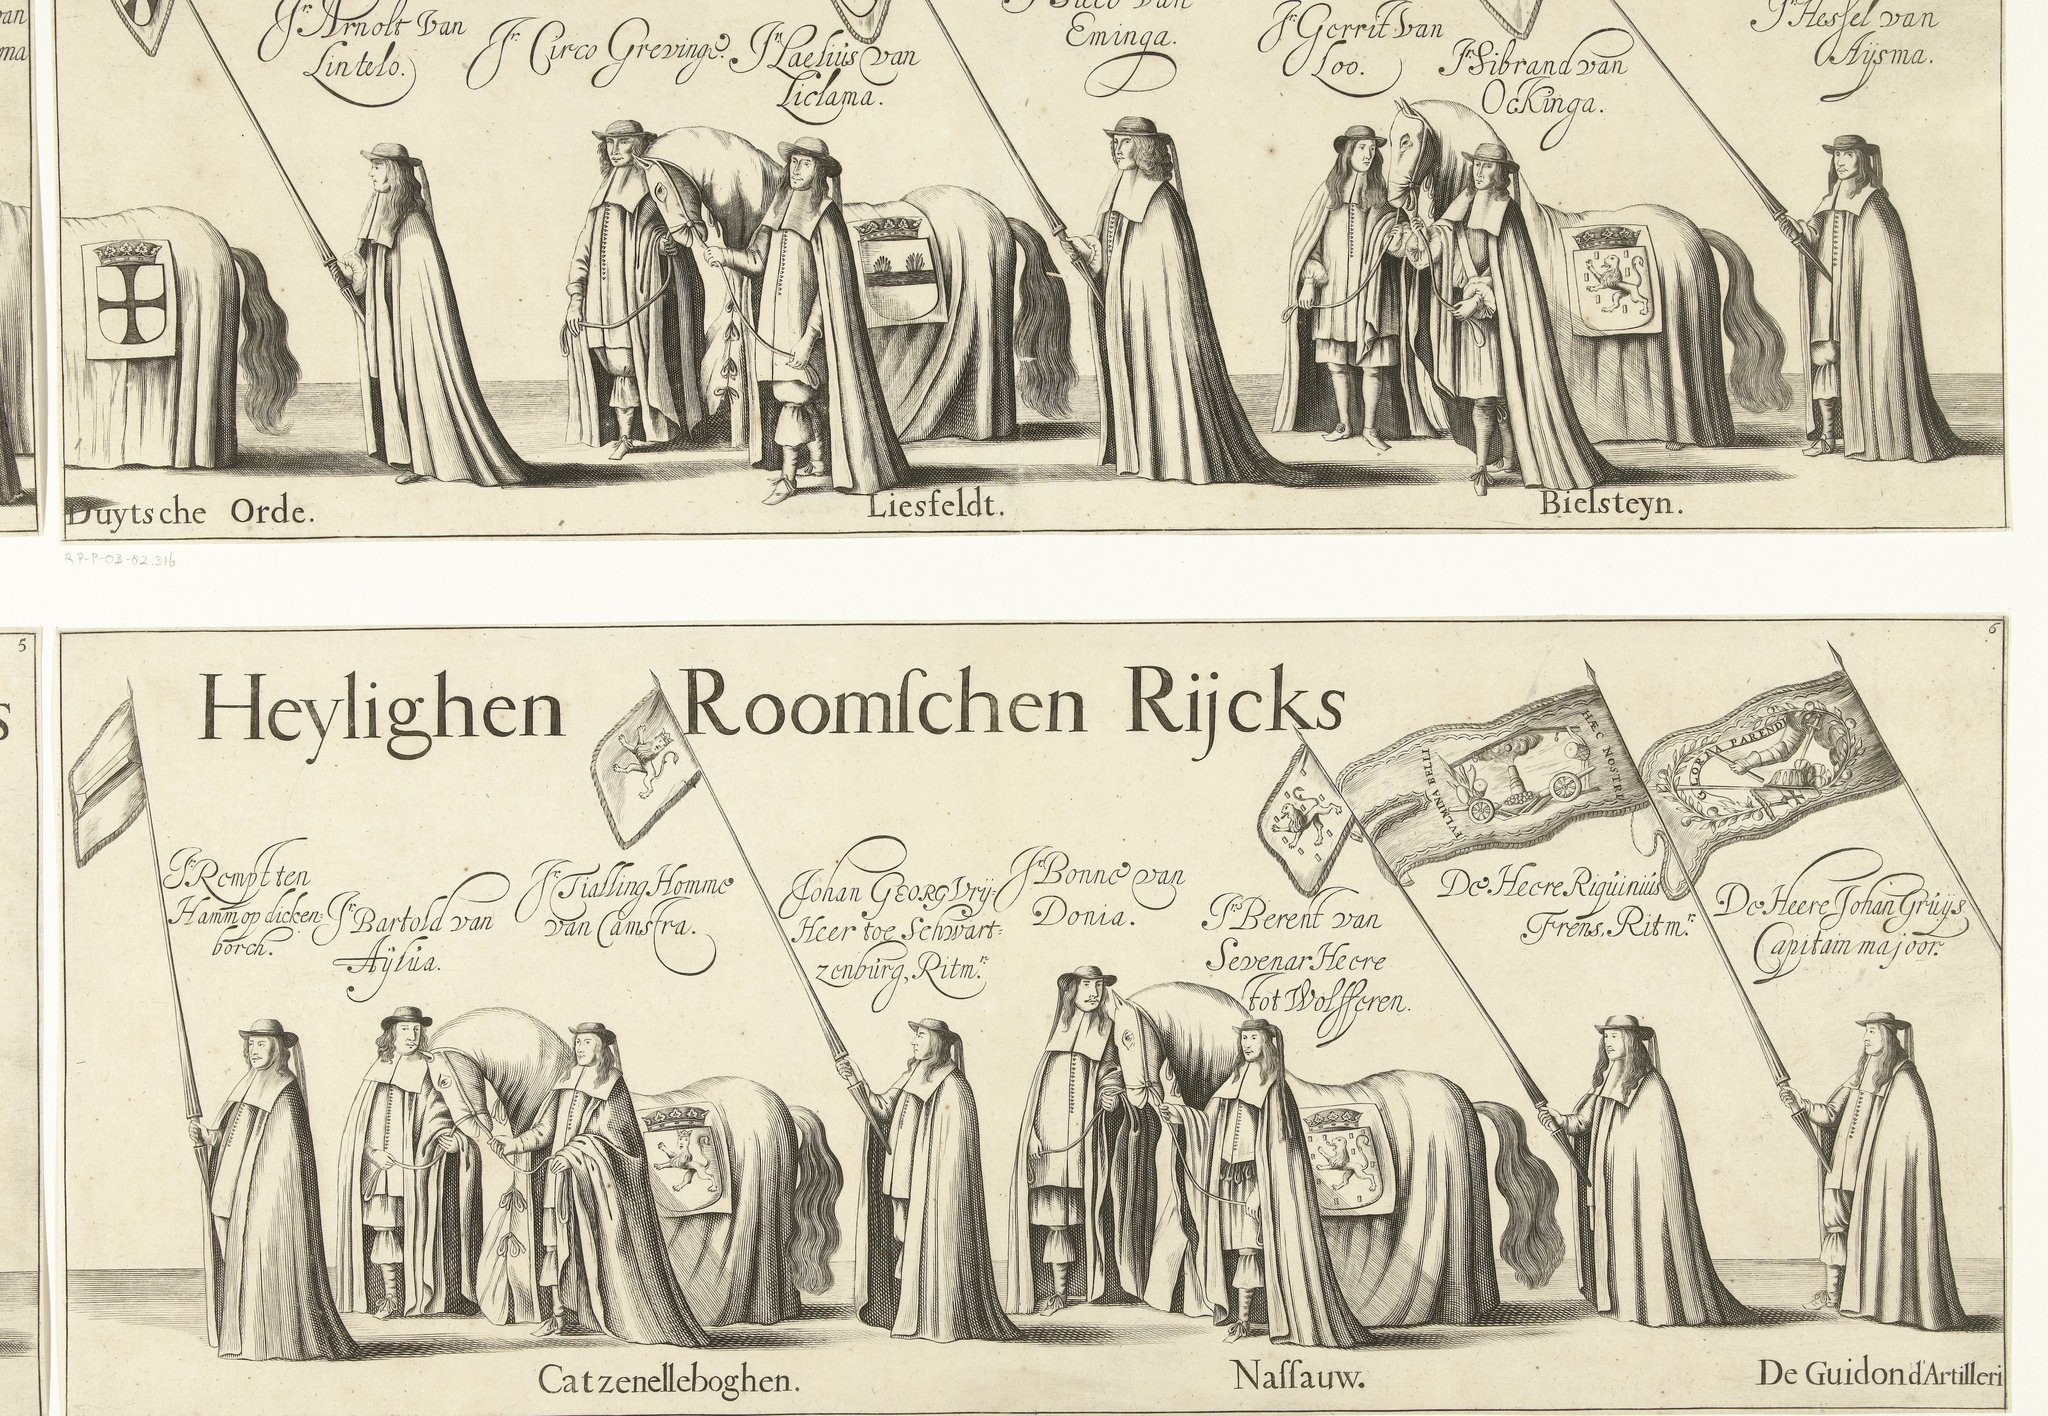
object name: print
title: Rouw-Staetelijcke Lijk-pracht in de Uyt-Vaert en Begraefenisse van het ont-zielde Lichaem van (...) Wilhelm Frederich (...) Overleden binnen Leeuwarden (...) den een-en-twintichsten October, MDCLXIV. en aldaer in 't Choor van de Jacobijner Kerck, den vyfthienden december MDCLXIV. Oude Stijl (...)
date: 1666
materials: paper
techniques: engraving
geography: leeuwarden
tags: arnhem, cortege, funeral procession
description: Begrafenisoptocht van Willem Frederik, graaf van Nassau-Dietz, in Leeuwarden op 6 januari 1665. Deel van de begrafenisstoet. Plaat nr. 6 in een ensemble van 24 (van de 25) ongemonteerde genummerde platen (zonder tekstbladen) die samen een lange fries vormen.